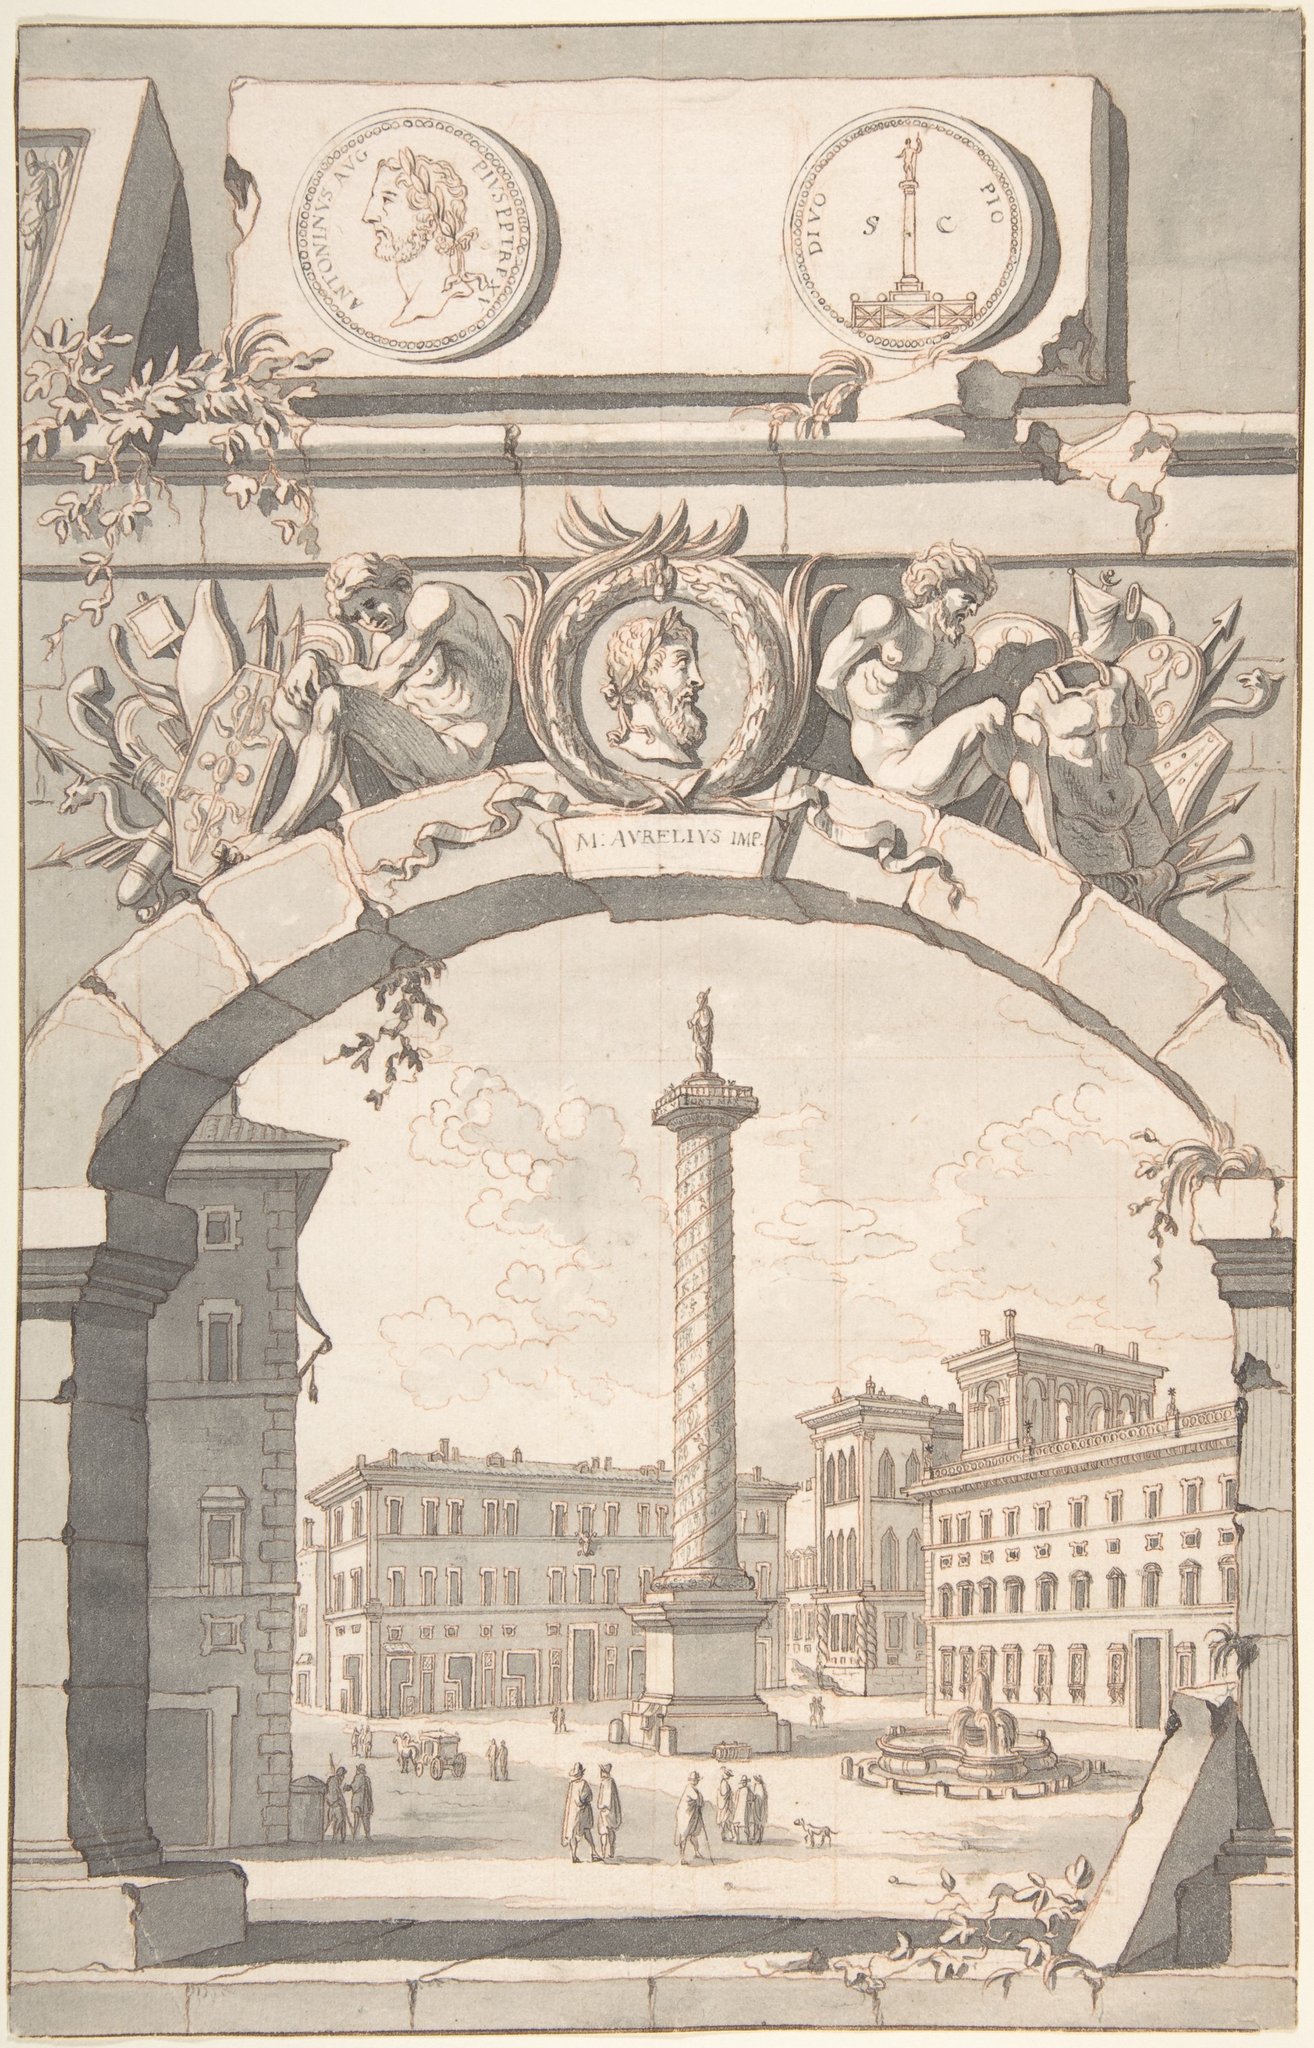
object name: drawing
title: View of the Column of Marcus Aurelius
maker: jan goeree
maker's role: artist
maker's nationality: dutch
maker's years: 1670-1731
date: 1704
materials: chalk, ink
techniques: brush, pen, drawing, wash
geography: italy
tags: buildings,columns,men,profiles